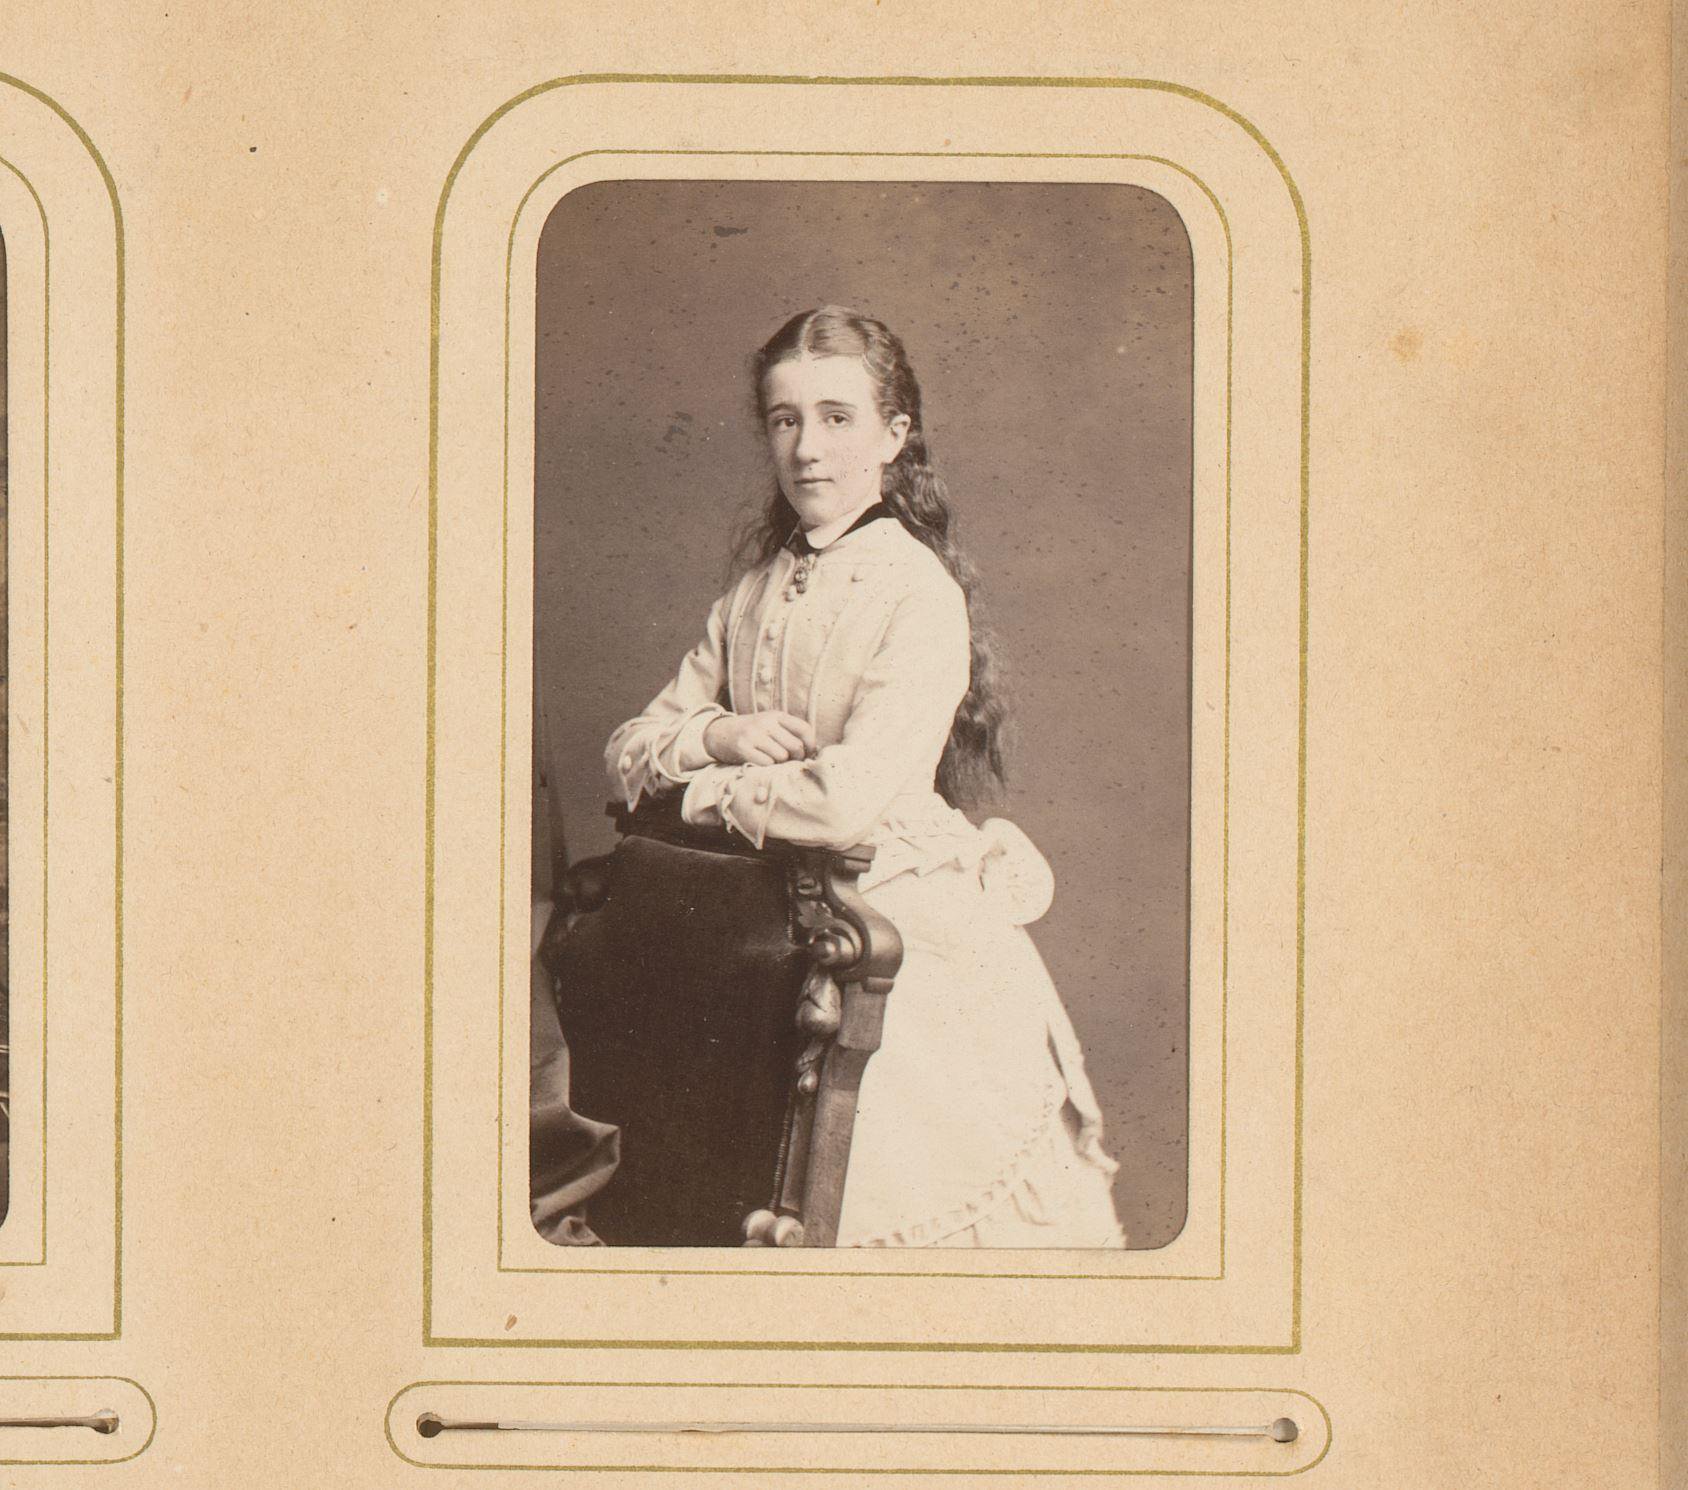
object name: carte de visite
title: Portret van een staand meisje, leunend op de leuning van een stoel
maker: a. böeseken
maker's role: fotograaf, lithograaf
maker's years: 1834-1919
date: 1858-1890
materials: cardboard, photographic support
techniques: albumen print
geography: rotterdam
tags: historical persons - bb - woman, girl (child between toddler and youth), standing figure - aa - female human figure, chair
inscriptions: inscription: ‘A. Böeseken/ Photographisch Atelier/ ROTTERDAM/ Hoogstraat over de/ Vlasmarkt.’